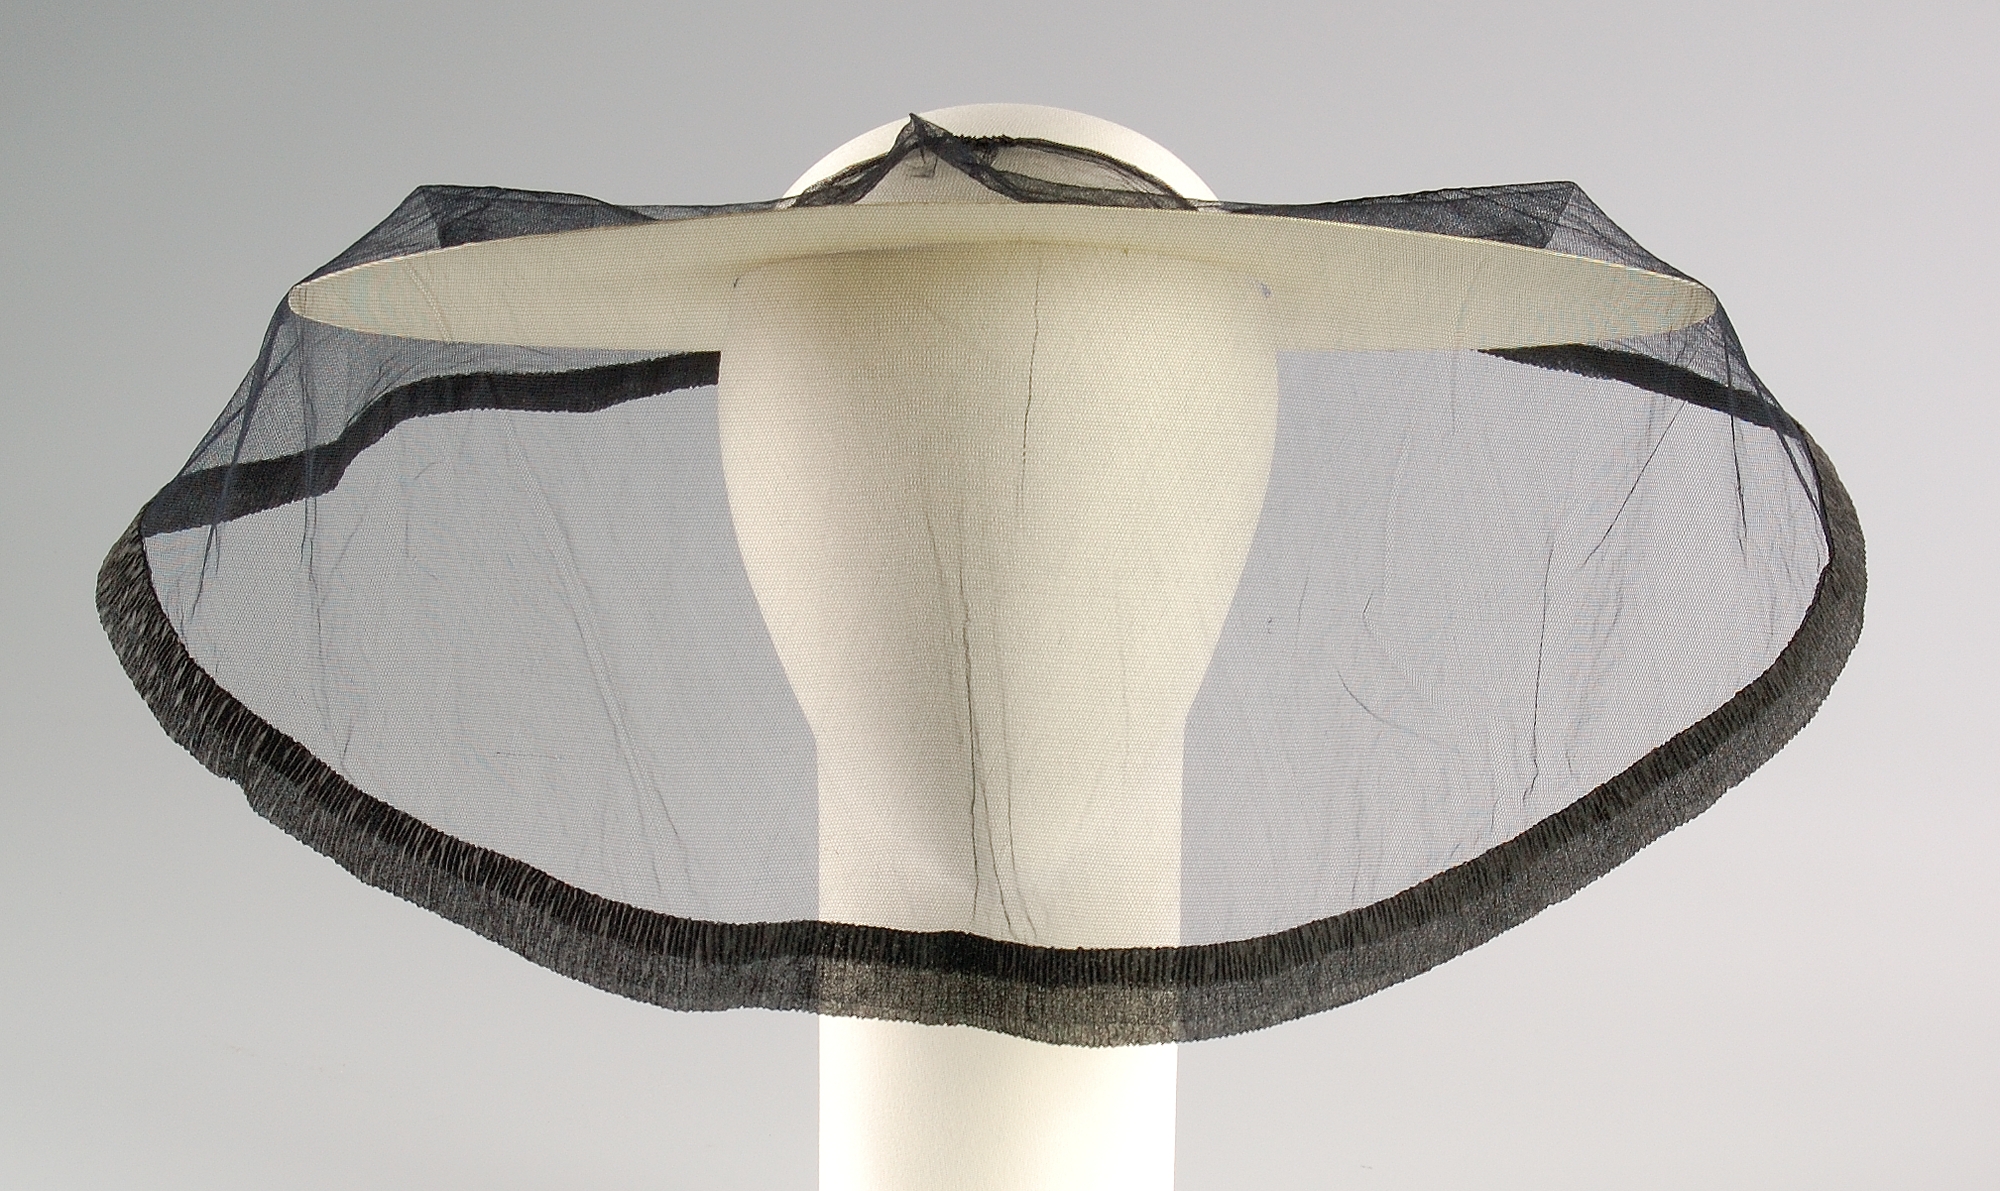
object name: mourning veil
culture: american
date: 1870-1875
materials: silk